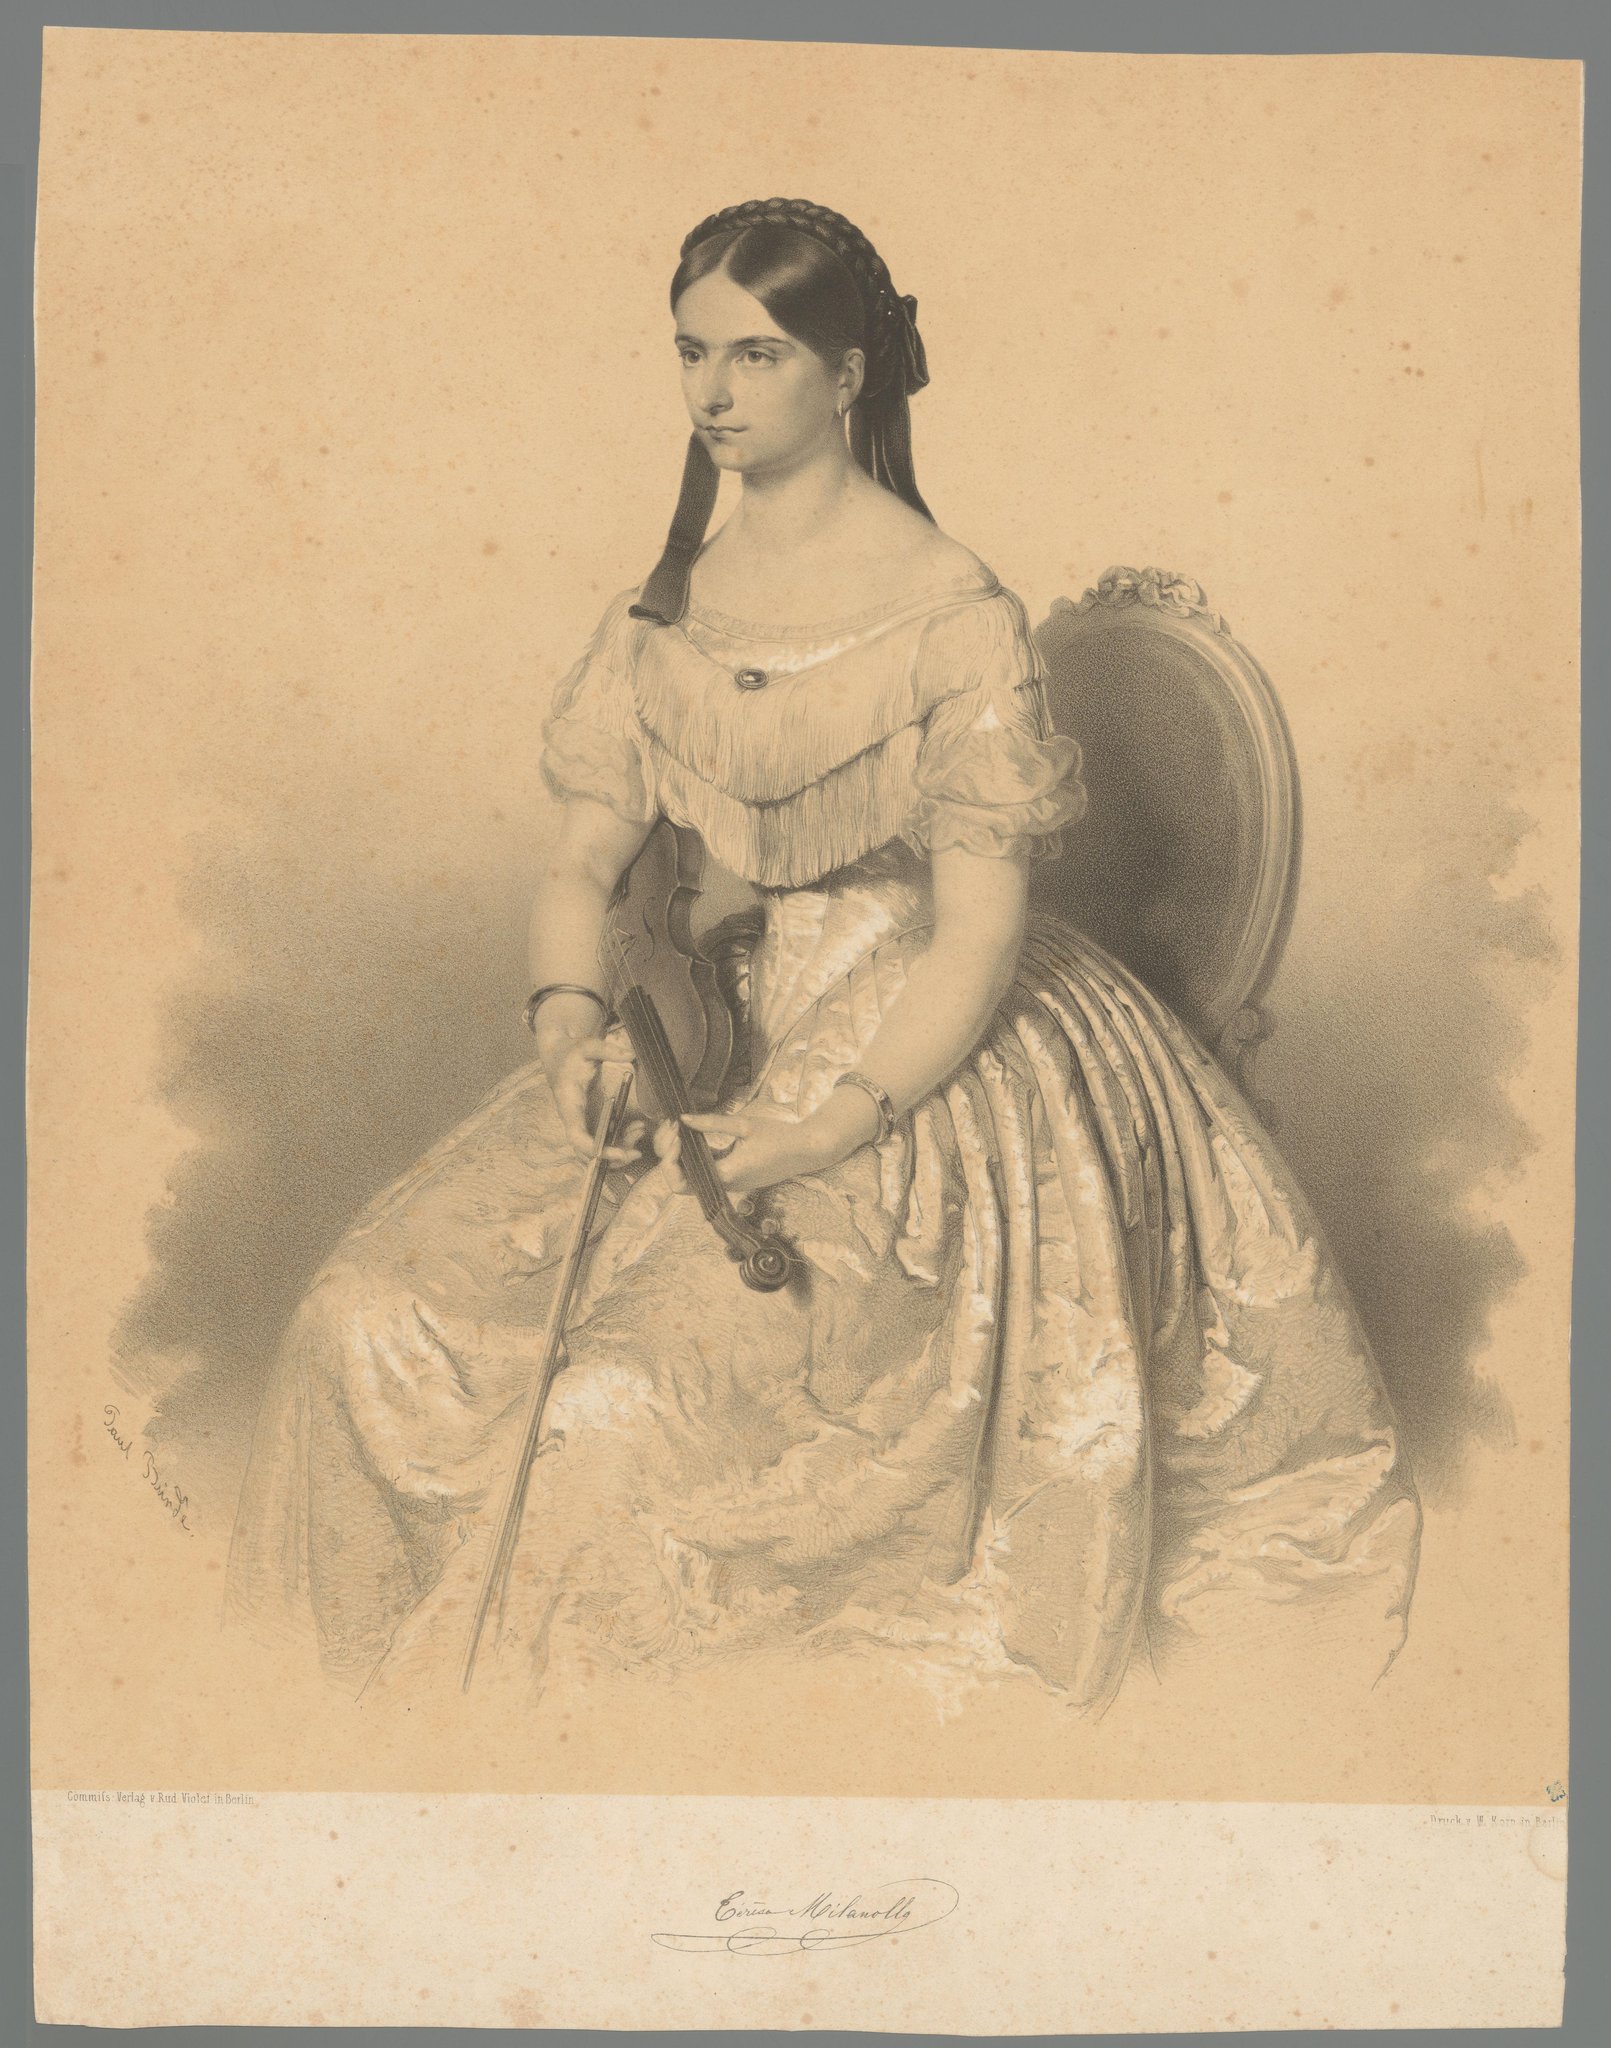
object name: print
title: Teresa Milanollo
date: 1829-1874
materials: paper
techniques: tone lithography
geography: berlin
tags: adult woman, historical persons, violin, fiddle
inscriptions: stamp, collector's mark: Lugt 2228